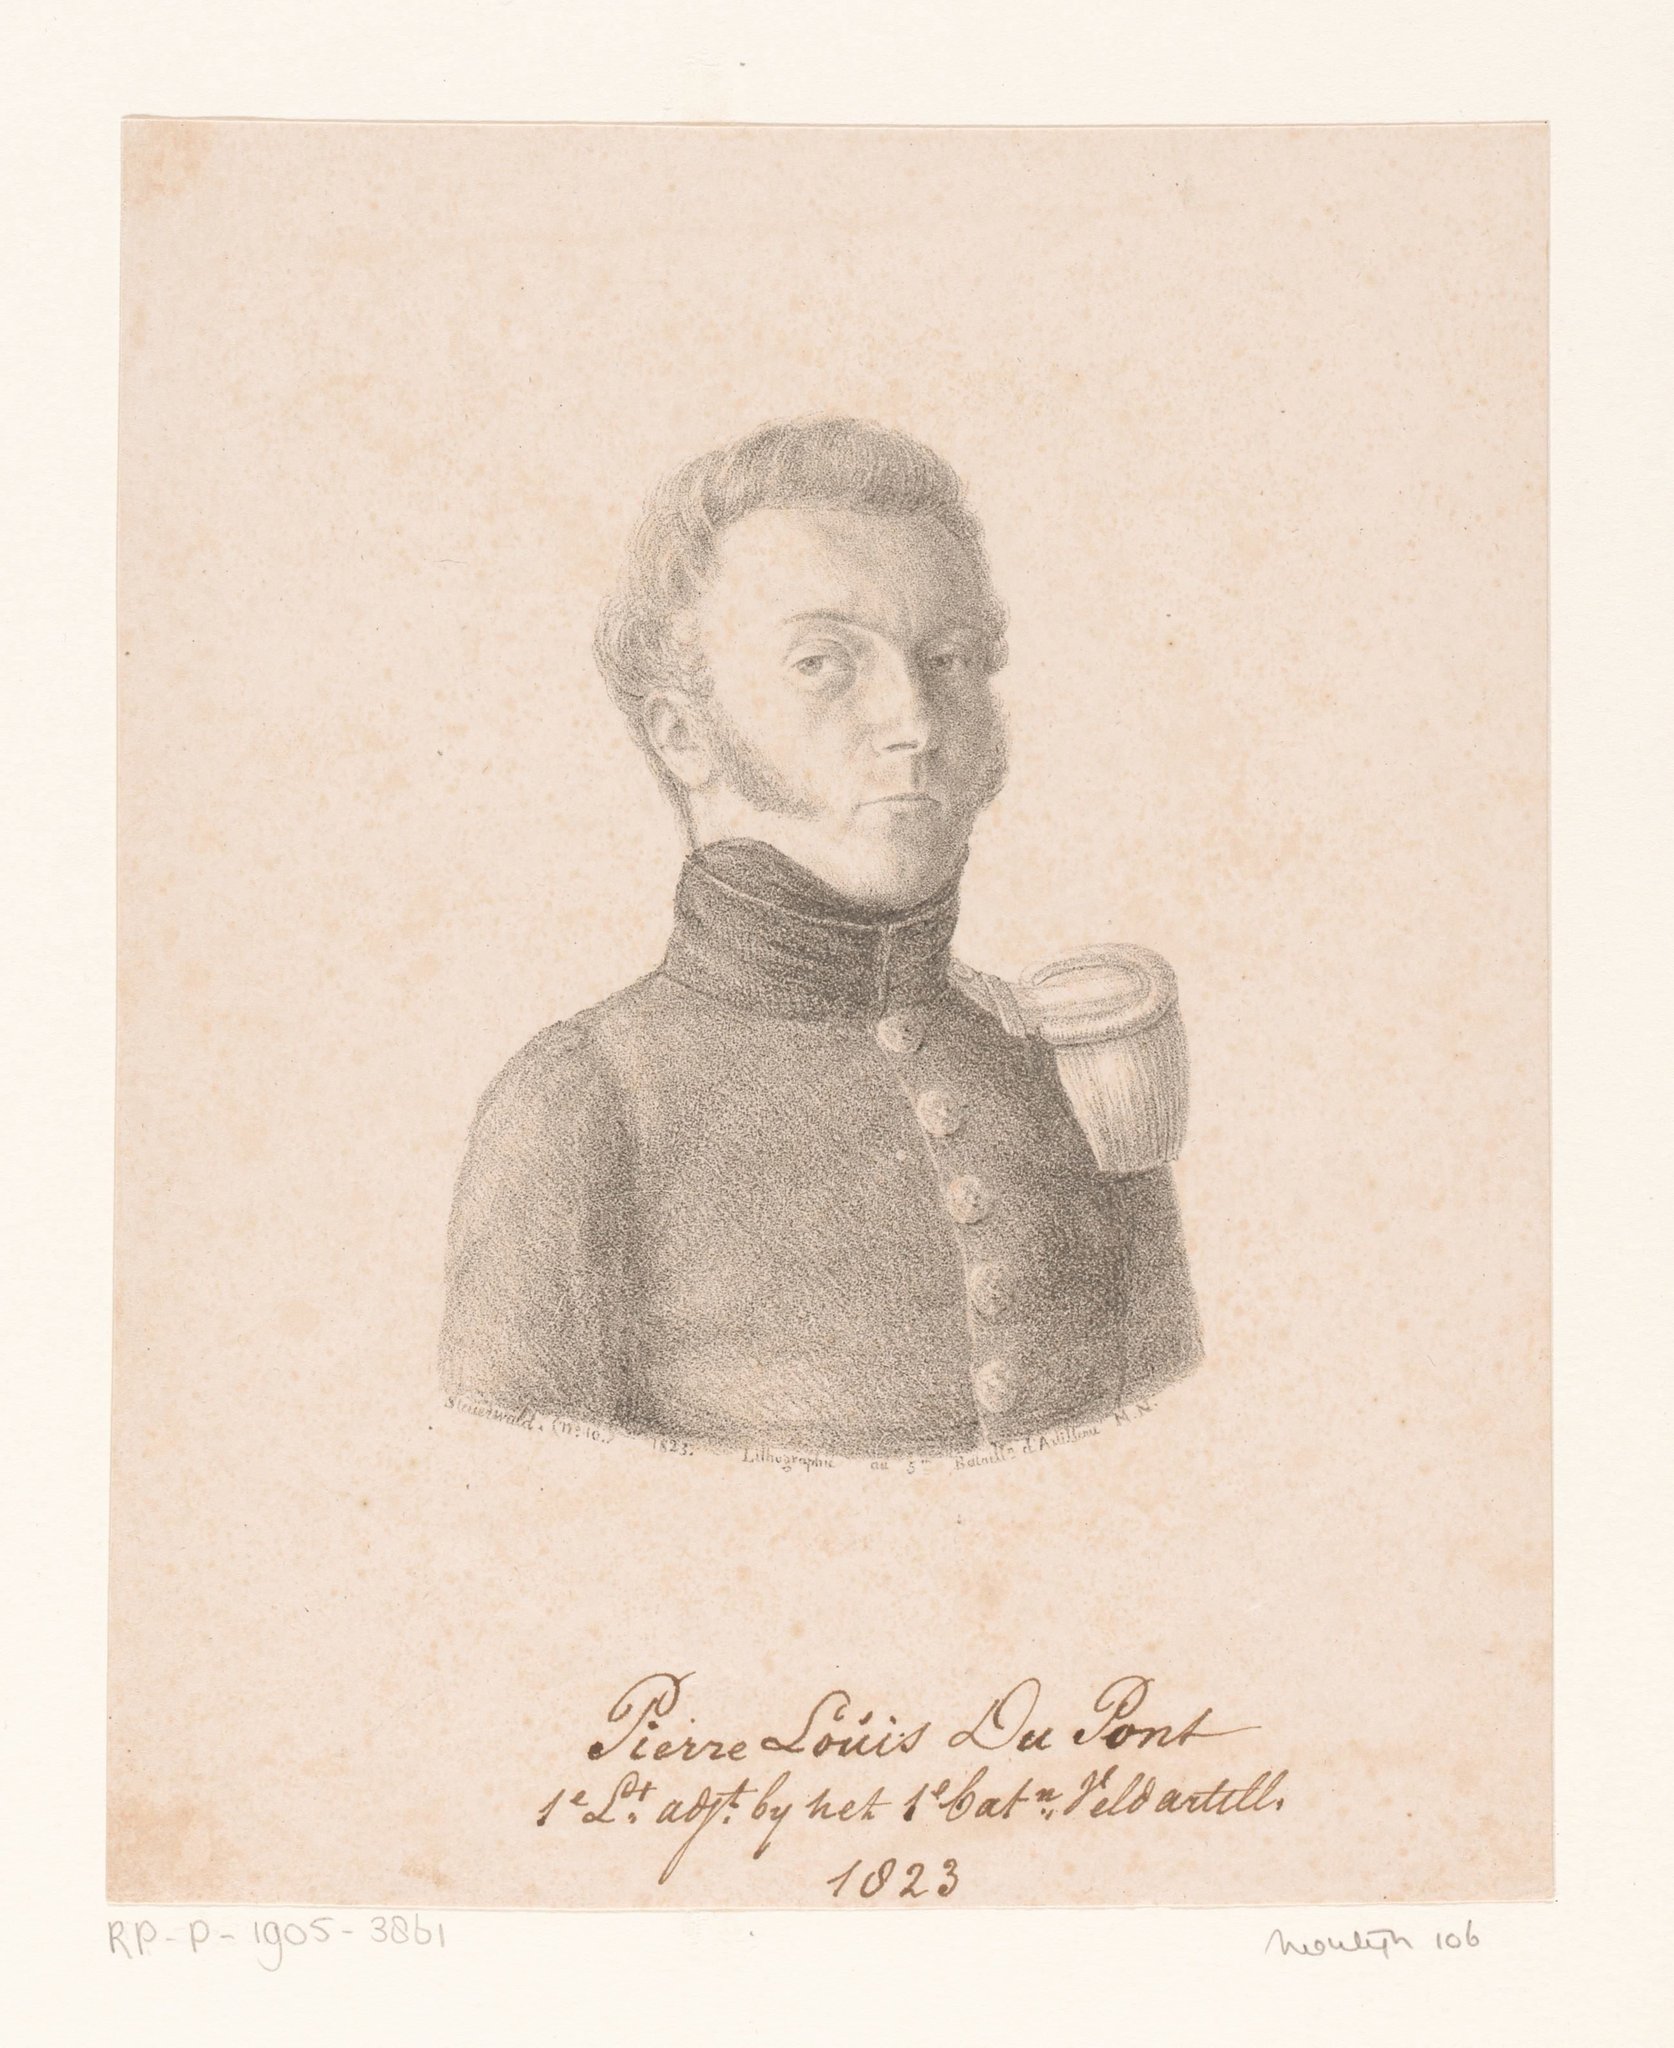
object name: print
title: Portret van Pierre Louis Du Pont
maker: christian heinrich gottlieb steuerwald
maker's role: draughtsman, print maker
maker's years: 1802-1874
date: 1823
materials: paper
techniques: lithograph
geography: dordrecht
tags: historical persons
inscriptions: collector's mark: Lugt 2228